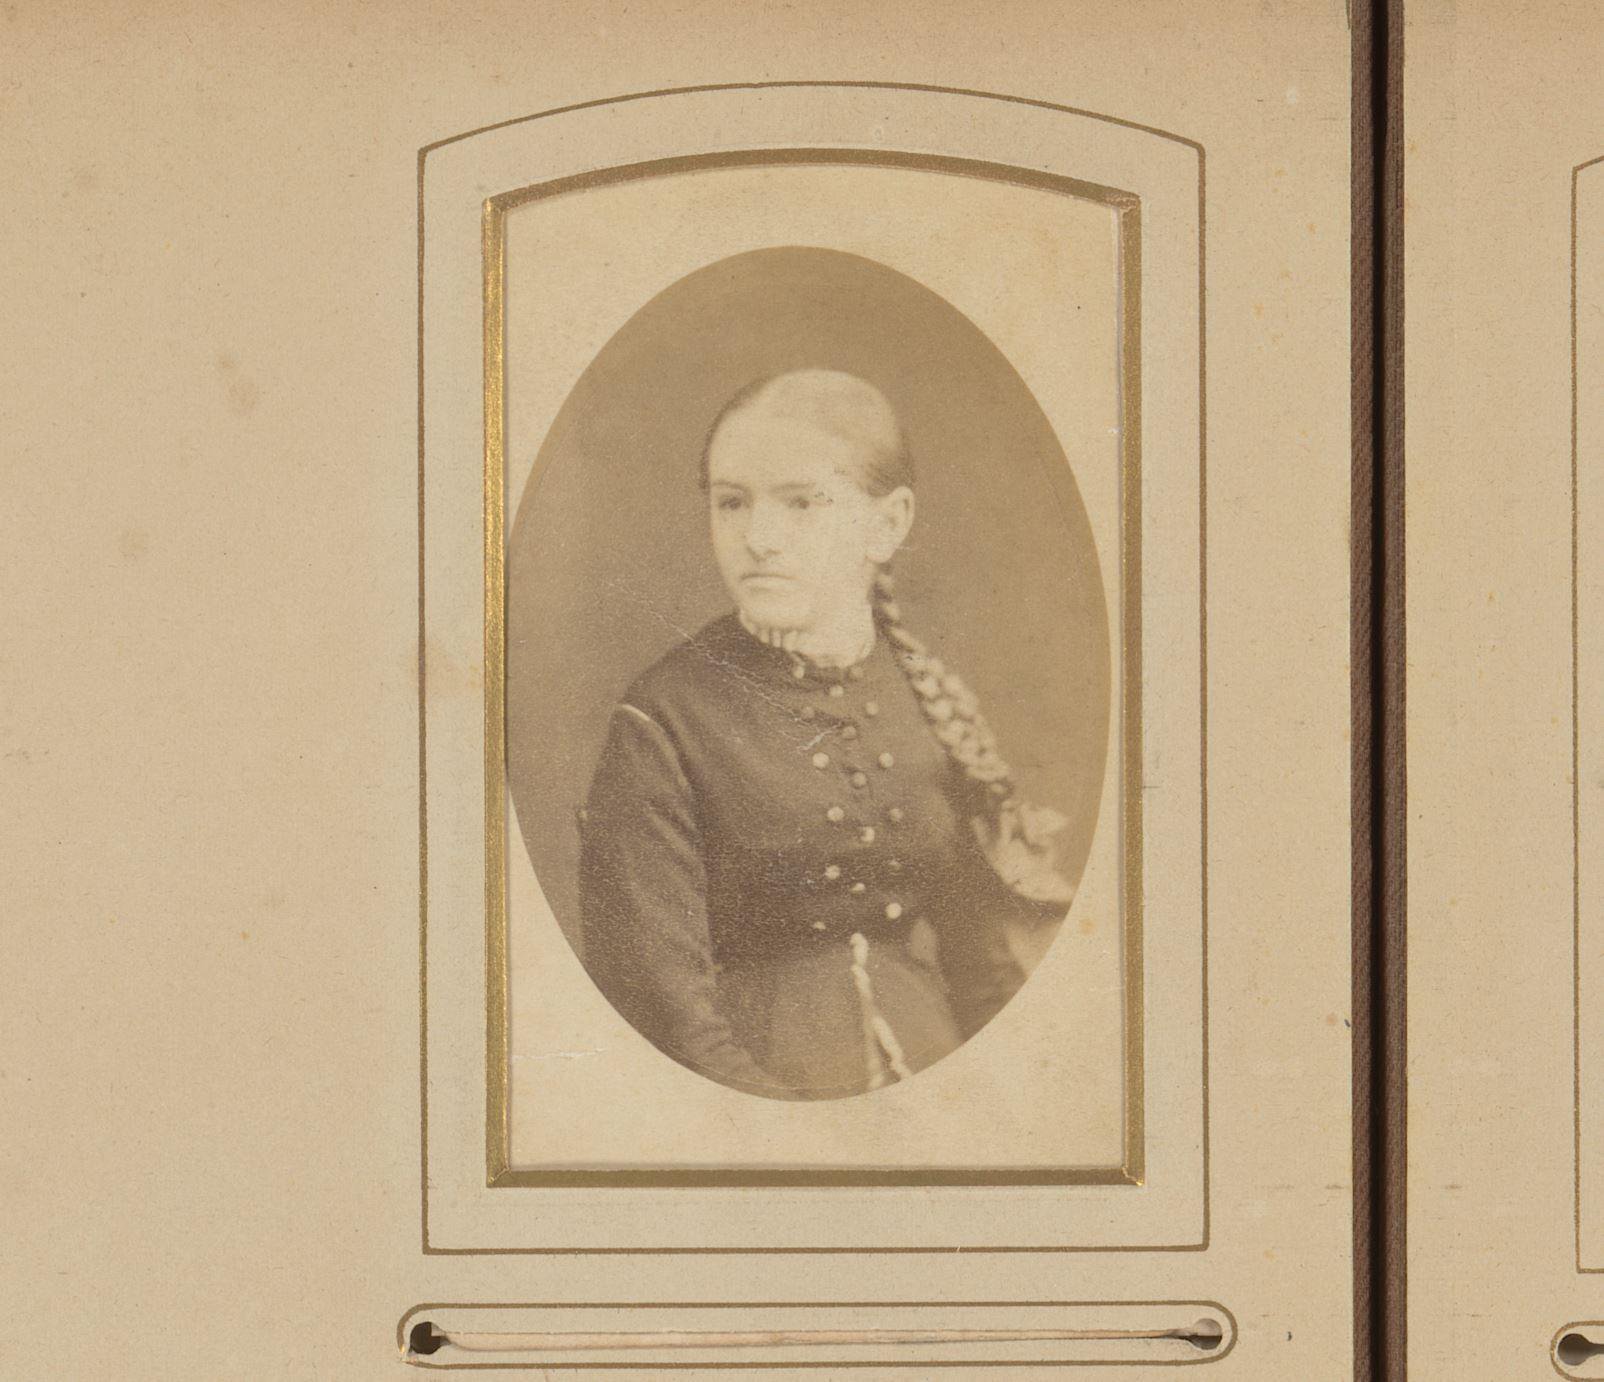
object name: carte de visite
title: Portret van een meisje met vlecht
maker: victor barras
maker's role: fotograaf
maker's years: 1845-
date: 1875-1900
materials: cardboard, photographic support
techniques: albumen print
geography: liège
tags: historical persons - bb - woman, girl (child between toddler and youth), hairdress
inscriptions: inscription: ‘V. BARRAS/ PHOTOGRAPHE/ 10, Passage Lemmonier, 10/ LIÈGE/ Les clichés sont conservés/ No...’